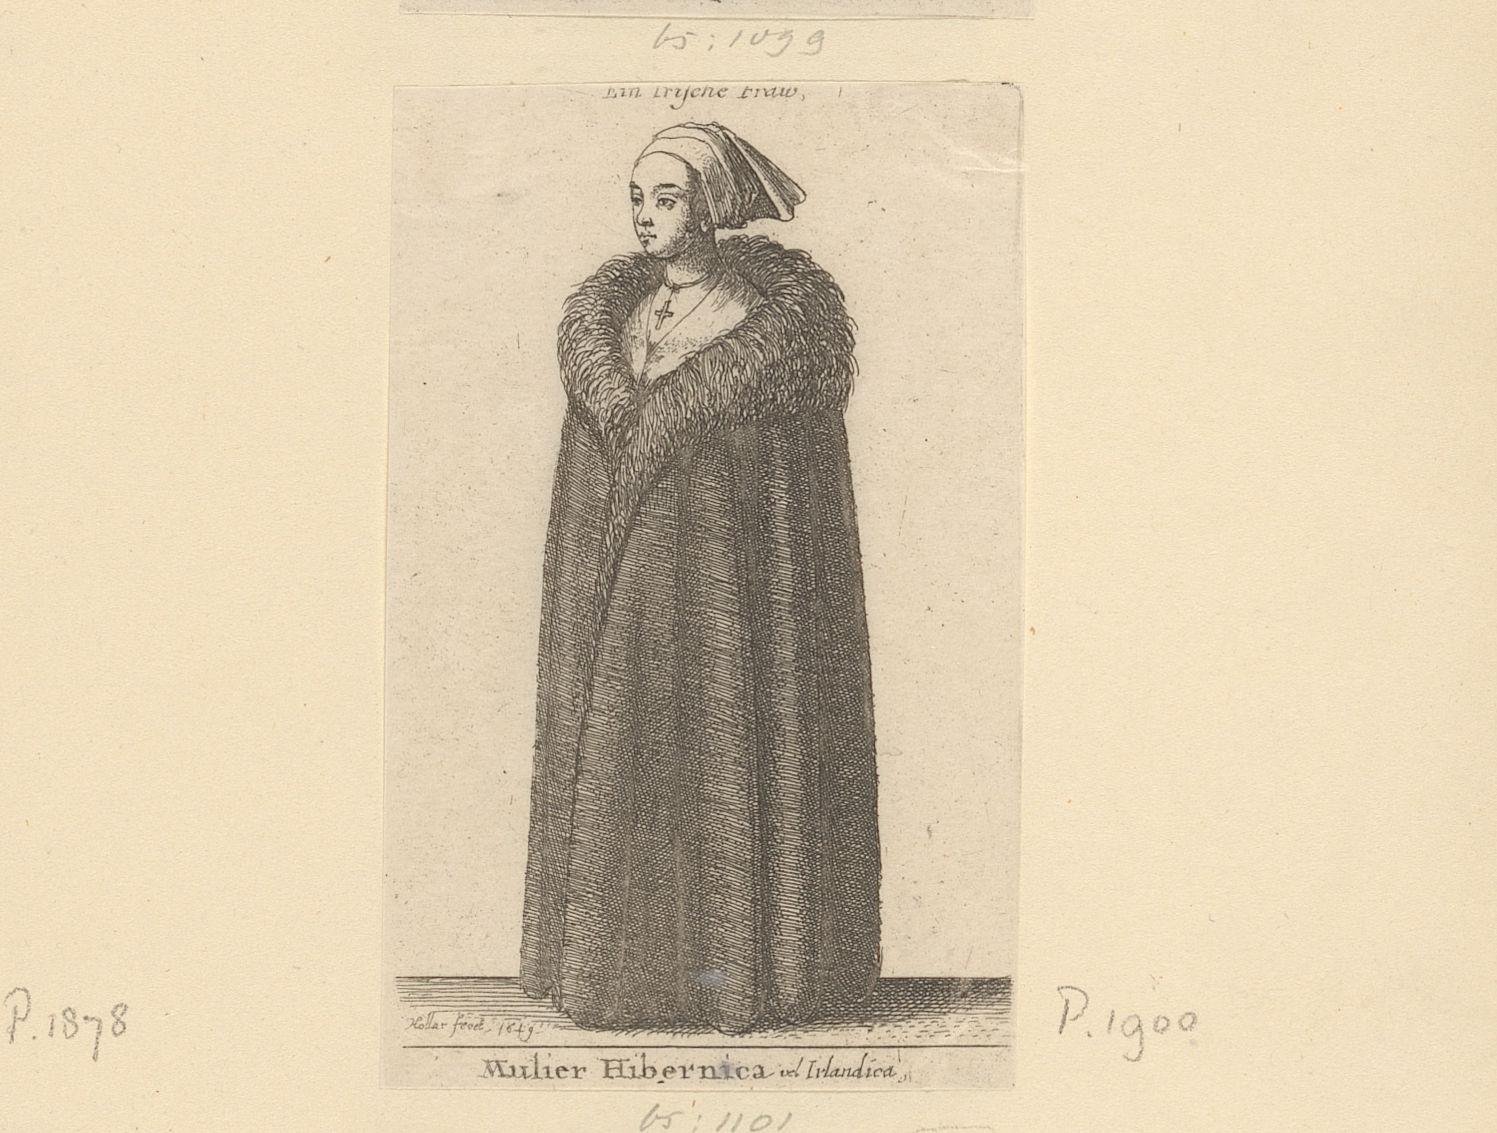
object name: print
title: Vrouw in klederdracht uit Ierland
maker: wenceslaus hollar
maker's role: draughtsman, print maker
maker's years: 1607-1677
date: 1649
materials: paper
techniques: etching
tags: adult woman, folk costume, regional costume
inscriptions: date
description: Prent maakt mogelijk deel uit van een serie van 200 prenten. Deze serie is onder de titel 'A Collection of two hundred original etchings' voor het eerst uitgegeven door J.M. Greery in 1816.